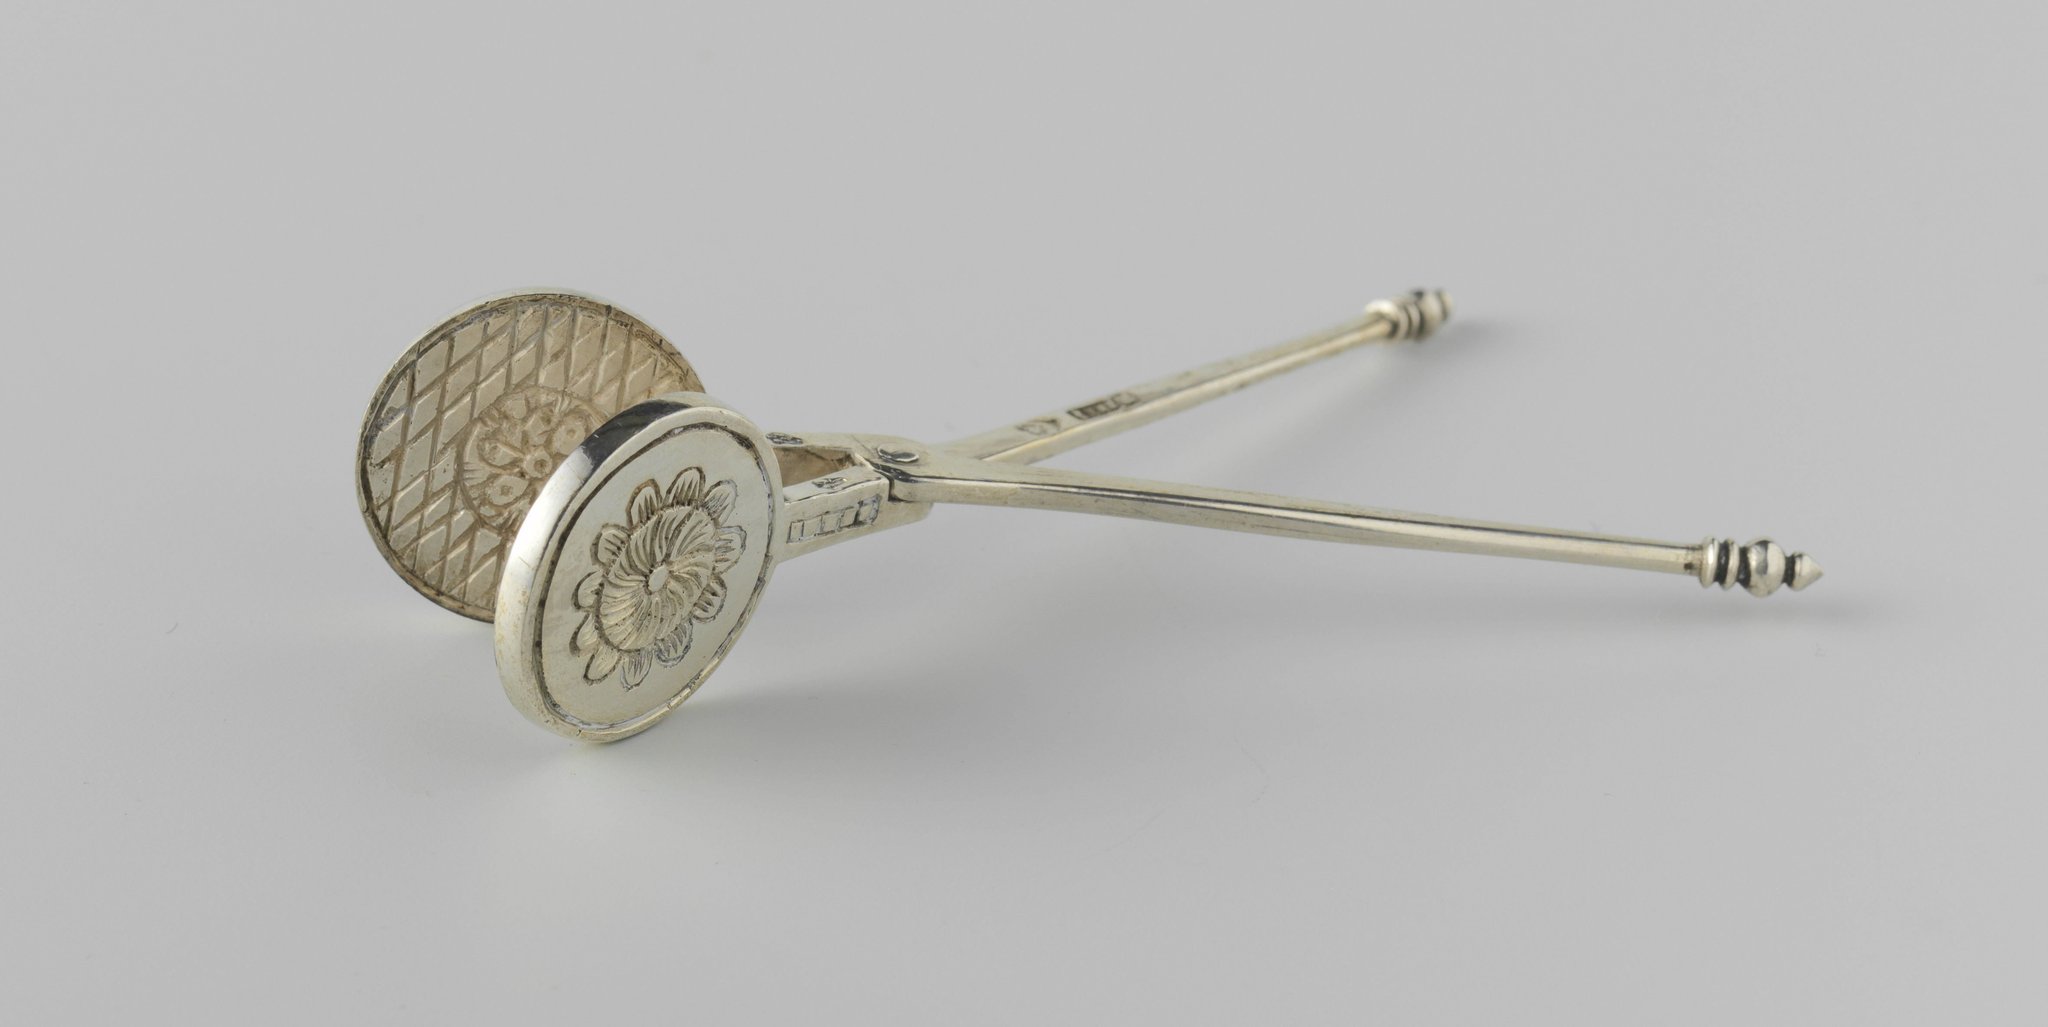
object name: miniature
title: Wafelijzer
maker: arnoldus van geffen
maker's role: silversmith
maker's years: 1700-1769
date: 1769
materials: silver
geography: amsterdam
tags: kitchen-utensils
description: Wafelijzer met ronde ijzers en knoppen aan het uiteinde van de stelen. De ijzers zijn beide aan de buitenzijde met een bloem versierd. De binnenzijden van de ijzers zijn geruit. Het wafelijzer is gemerkt: stk.= Amsterdam, jrl.= K (1769), mt.= Arnoldus van Geffen en twee bijltjes.